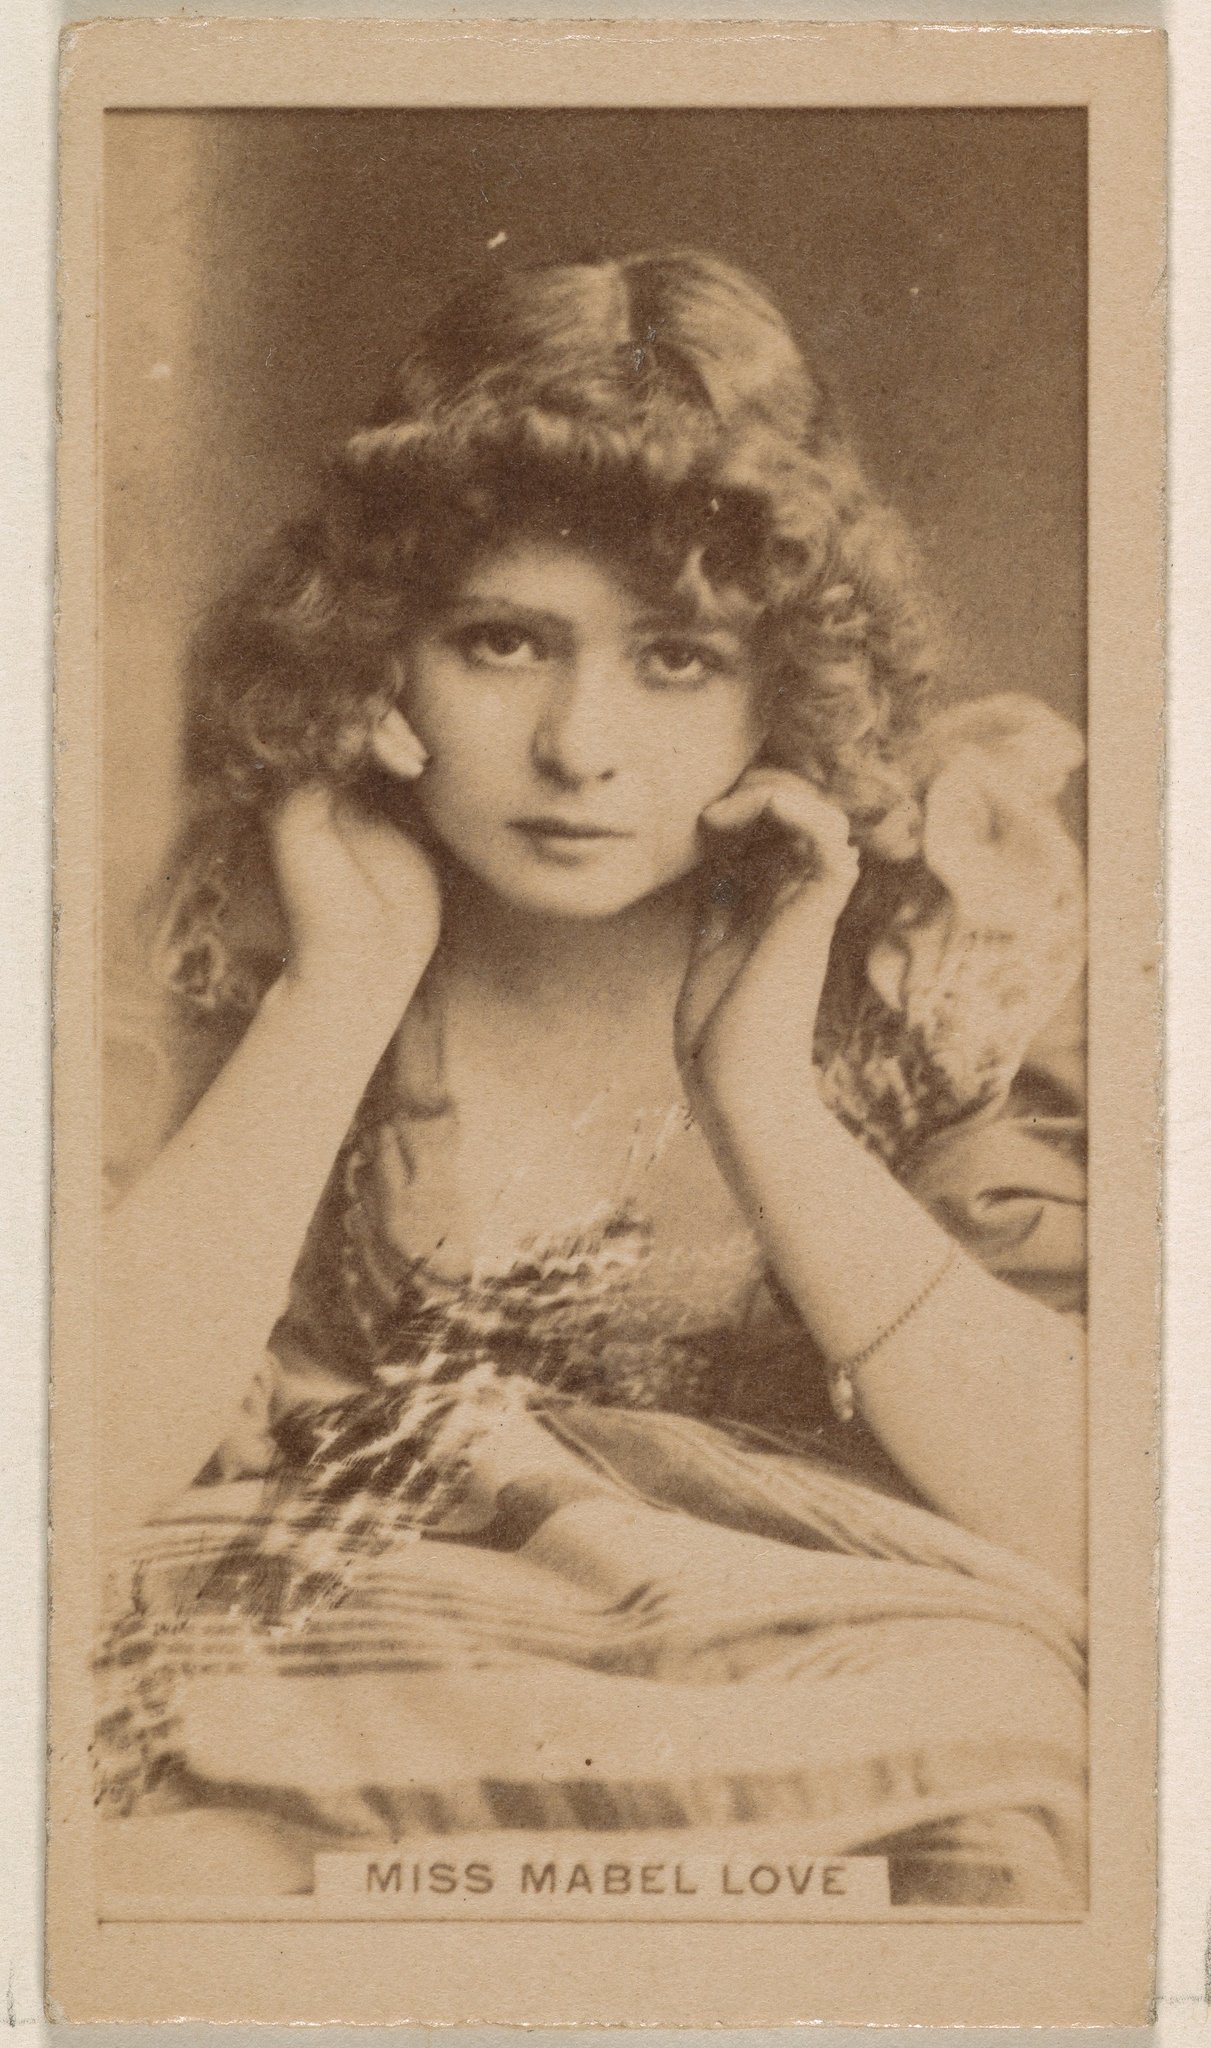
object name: photograph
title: Miss Mabel Love, from the Actresses series (N245) issued by Kinney Brothers to promote Sweet Caporal Cigarettes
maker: kinney brothers tobacco company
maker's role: publisher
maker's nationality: american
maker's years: 1869-2011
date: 1890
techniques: albumen silver print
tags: portraits,women,actresses